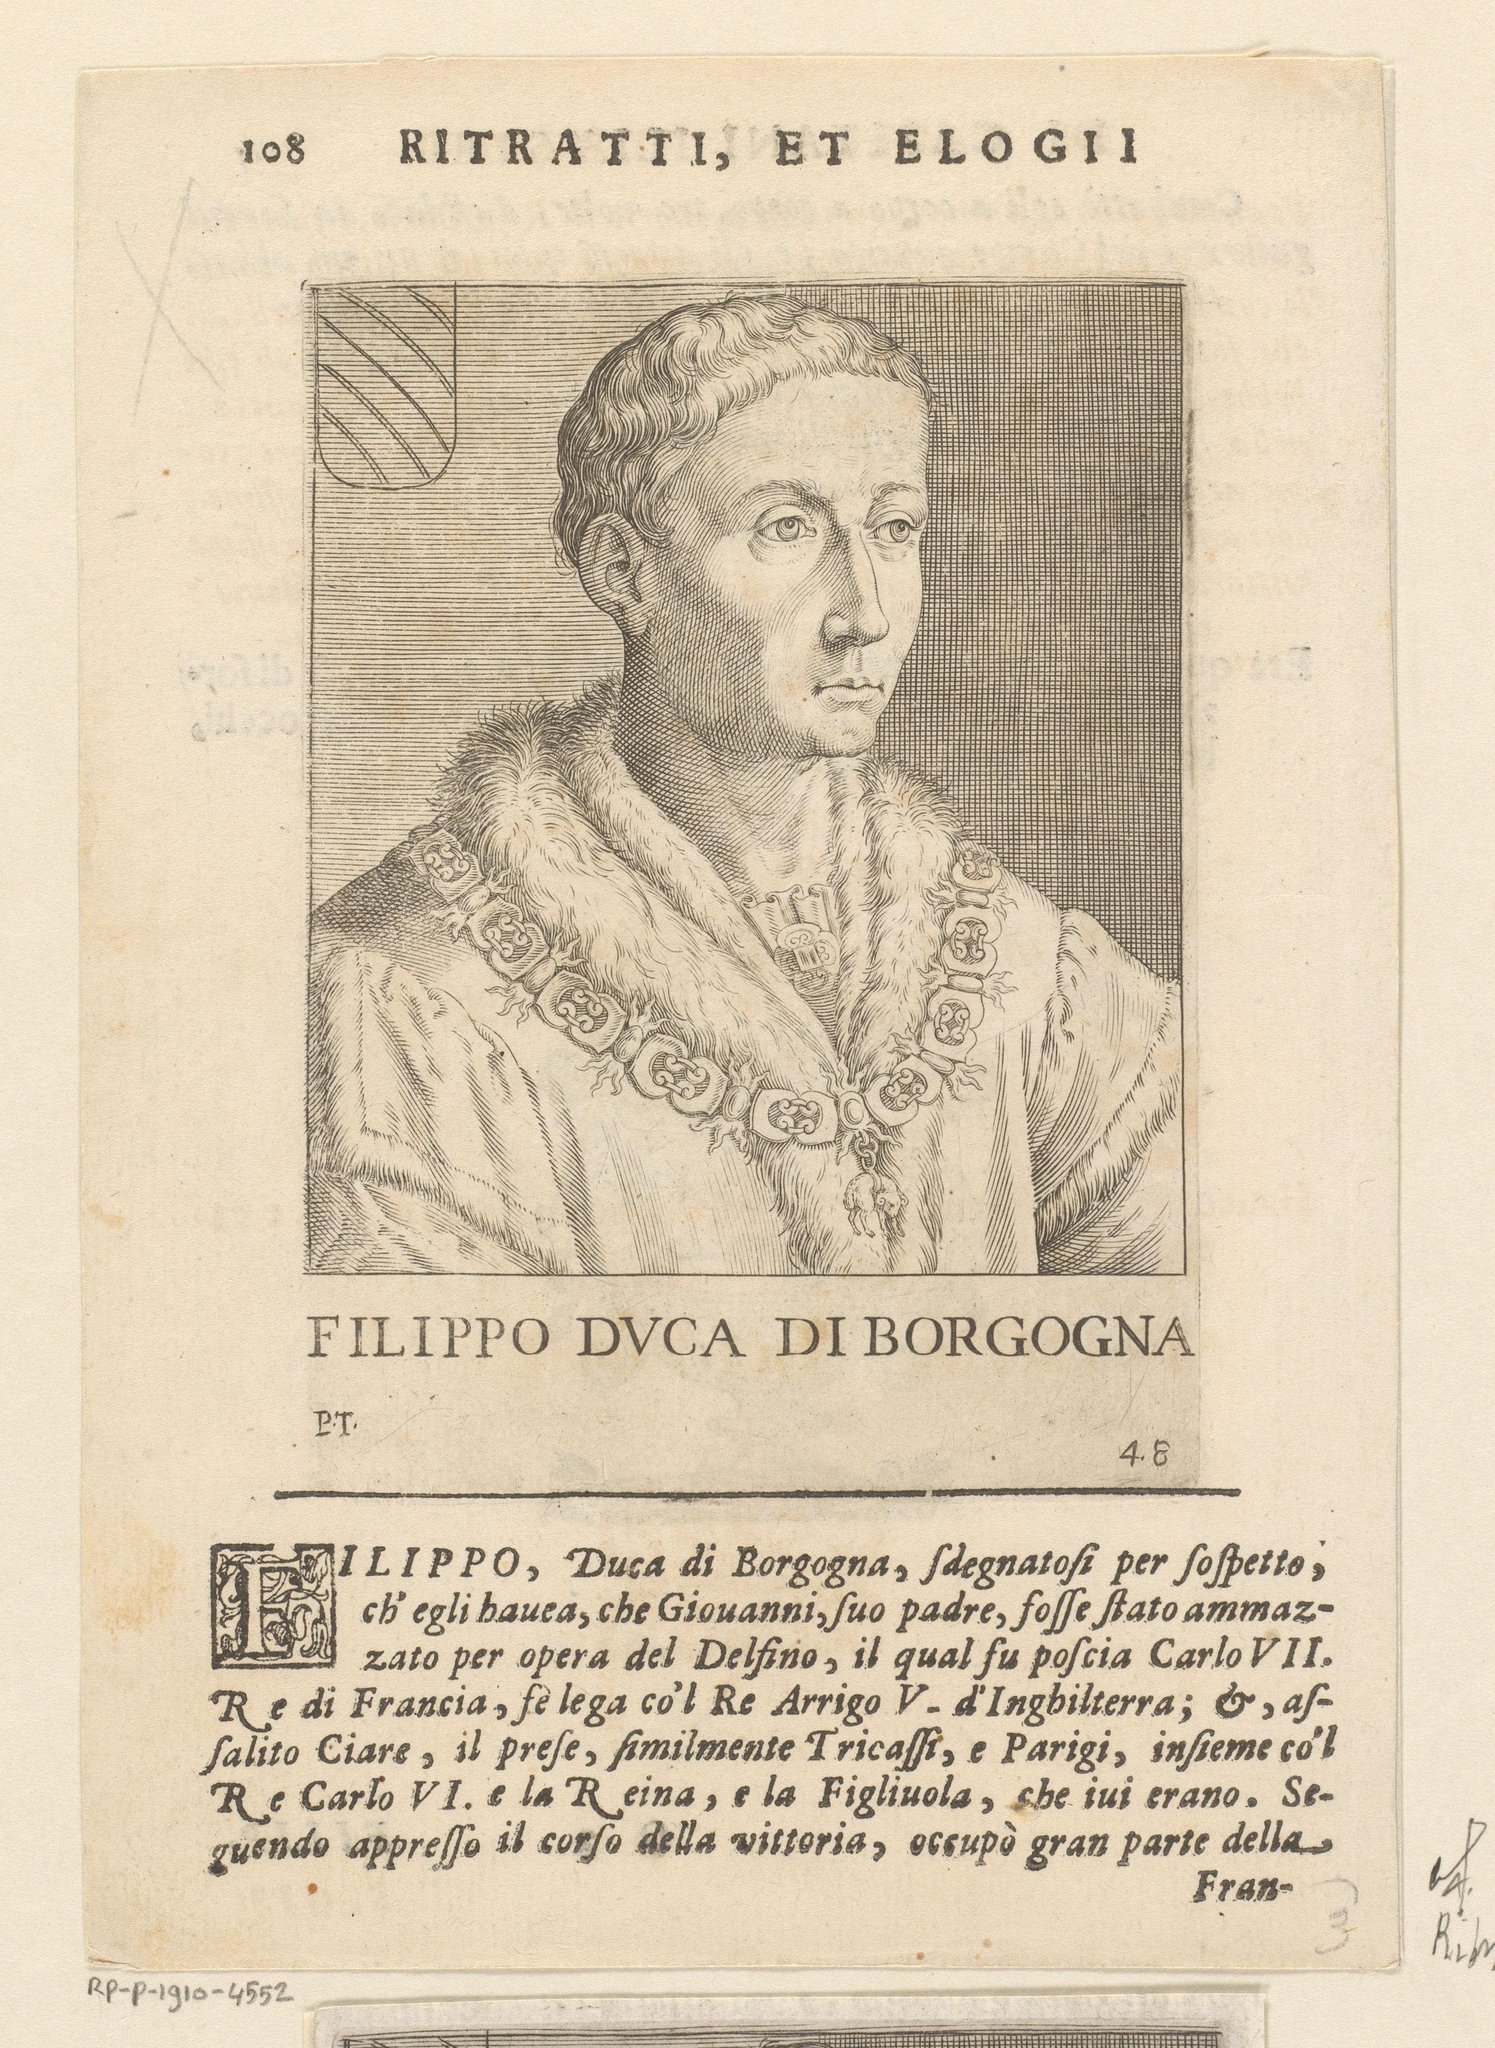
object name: print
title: Portret van Filips de Goede, hertog van Bourgondië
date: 1635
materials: paper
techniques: engraving, letterpress printing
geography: rome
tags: philip iii the good, historical persons, ruler, sovereign, armorial bearing, heraldry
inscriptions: collector's mark: Lugt 2228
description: Prent uit: Ritratti et elogii di capitani Illustri. Rome: Pompilio Totti en Andrea Fei, 1635, p. 108. Eerdere staat van prent in ieder geval ook gebruikt in: Ritratti di cento capitani illustri con li lor Fatti in guerra (…), Rome: Domenico Gigliotti, 1596. Latere staat van prent in ieder geval ook gebruikt in: Ritratti et elogii di capitani Illustri. Che ne'secoli moderni hanno gloriosamente guerreggiato. Rome: Filippo de'Rossi en Vitale Mascardi, 1646.